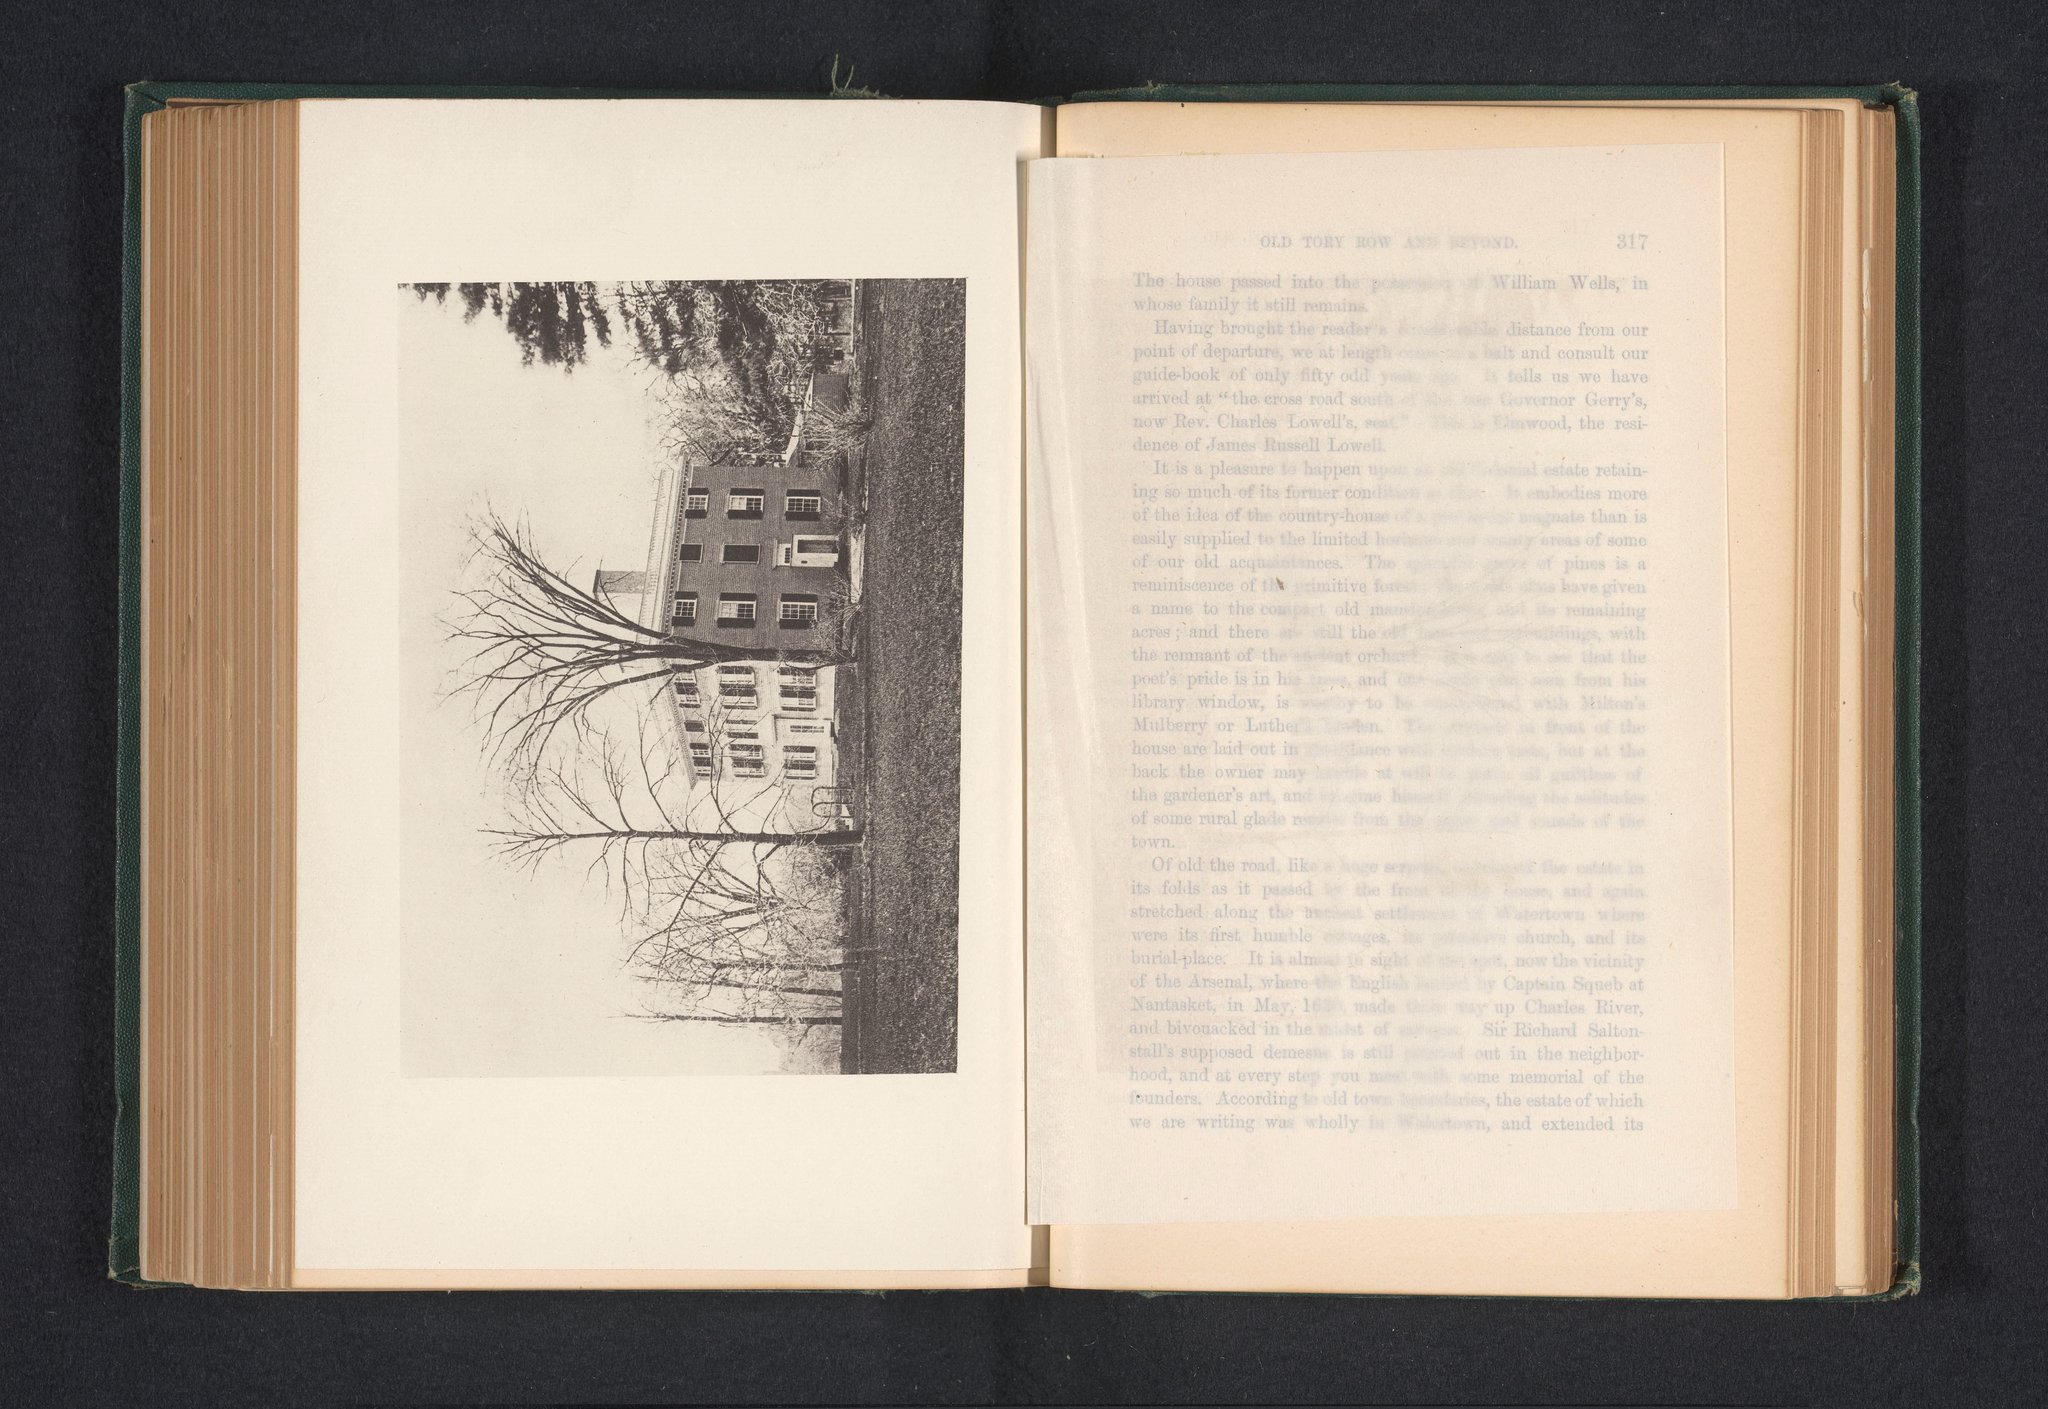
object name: page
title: Gezicht op het huis van James Russell Lowell te Cambridge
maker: Anonymous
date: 1869-1874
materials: paper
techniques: photograph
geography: cambridge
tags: rural housing, e.g. country-house, villa, cottage, façade (of house or building)